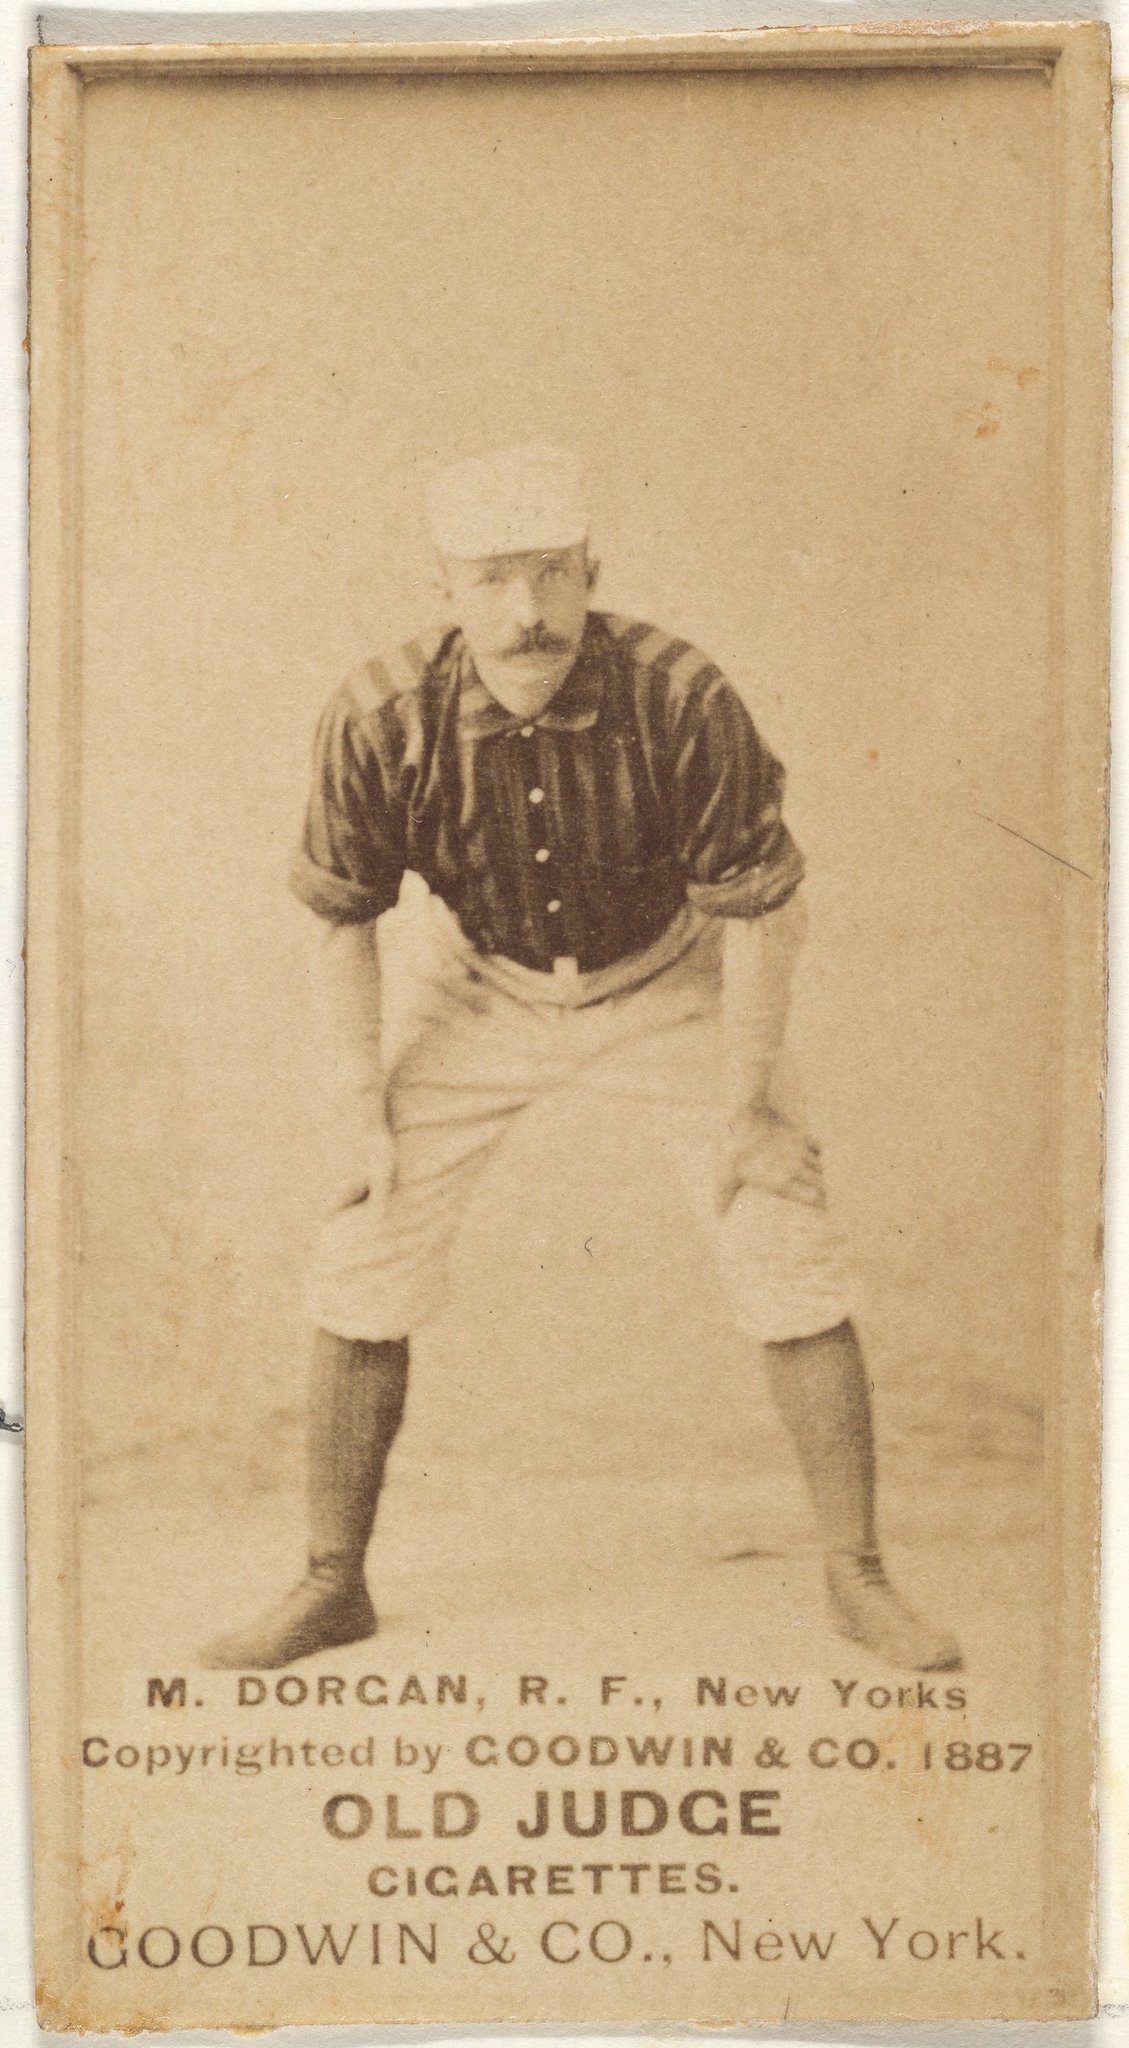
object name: baseball card, photograph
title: Michael Cornelius Dorgan, Right Field, New York, from the Old Judge series (N172) for Old Judge Cigarettes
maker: goodwin & company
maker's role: publisher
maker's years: 1850-1950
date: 1887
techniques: albumen silver print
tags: men,portraits,baseball,athletes